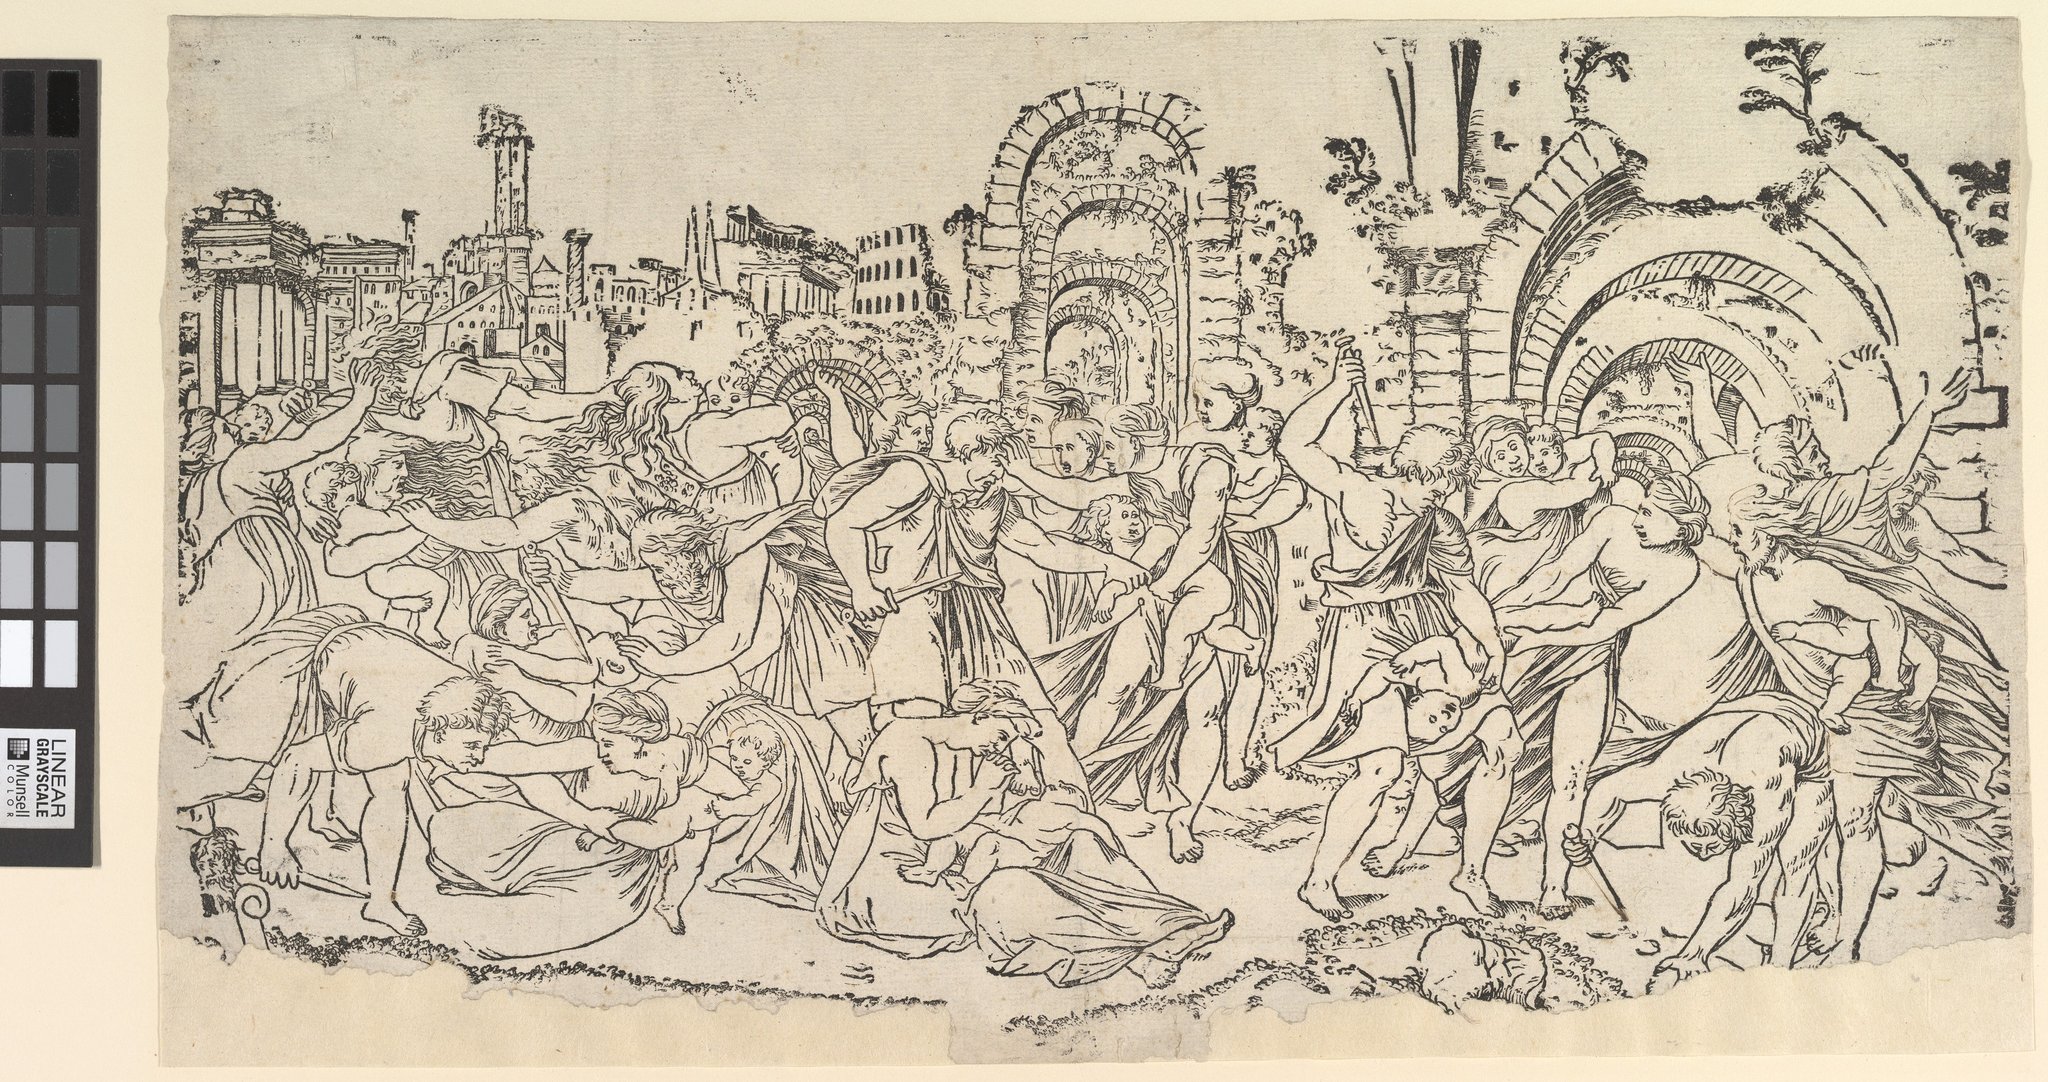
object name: print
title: Massacre of the Innocents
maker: master nd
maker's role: artist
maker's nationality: italian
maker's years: 1540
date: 1544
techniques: woodcut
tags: massacres,suffering,children,men,women